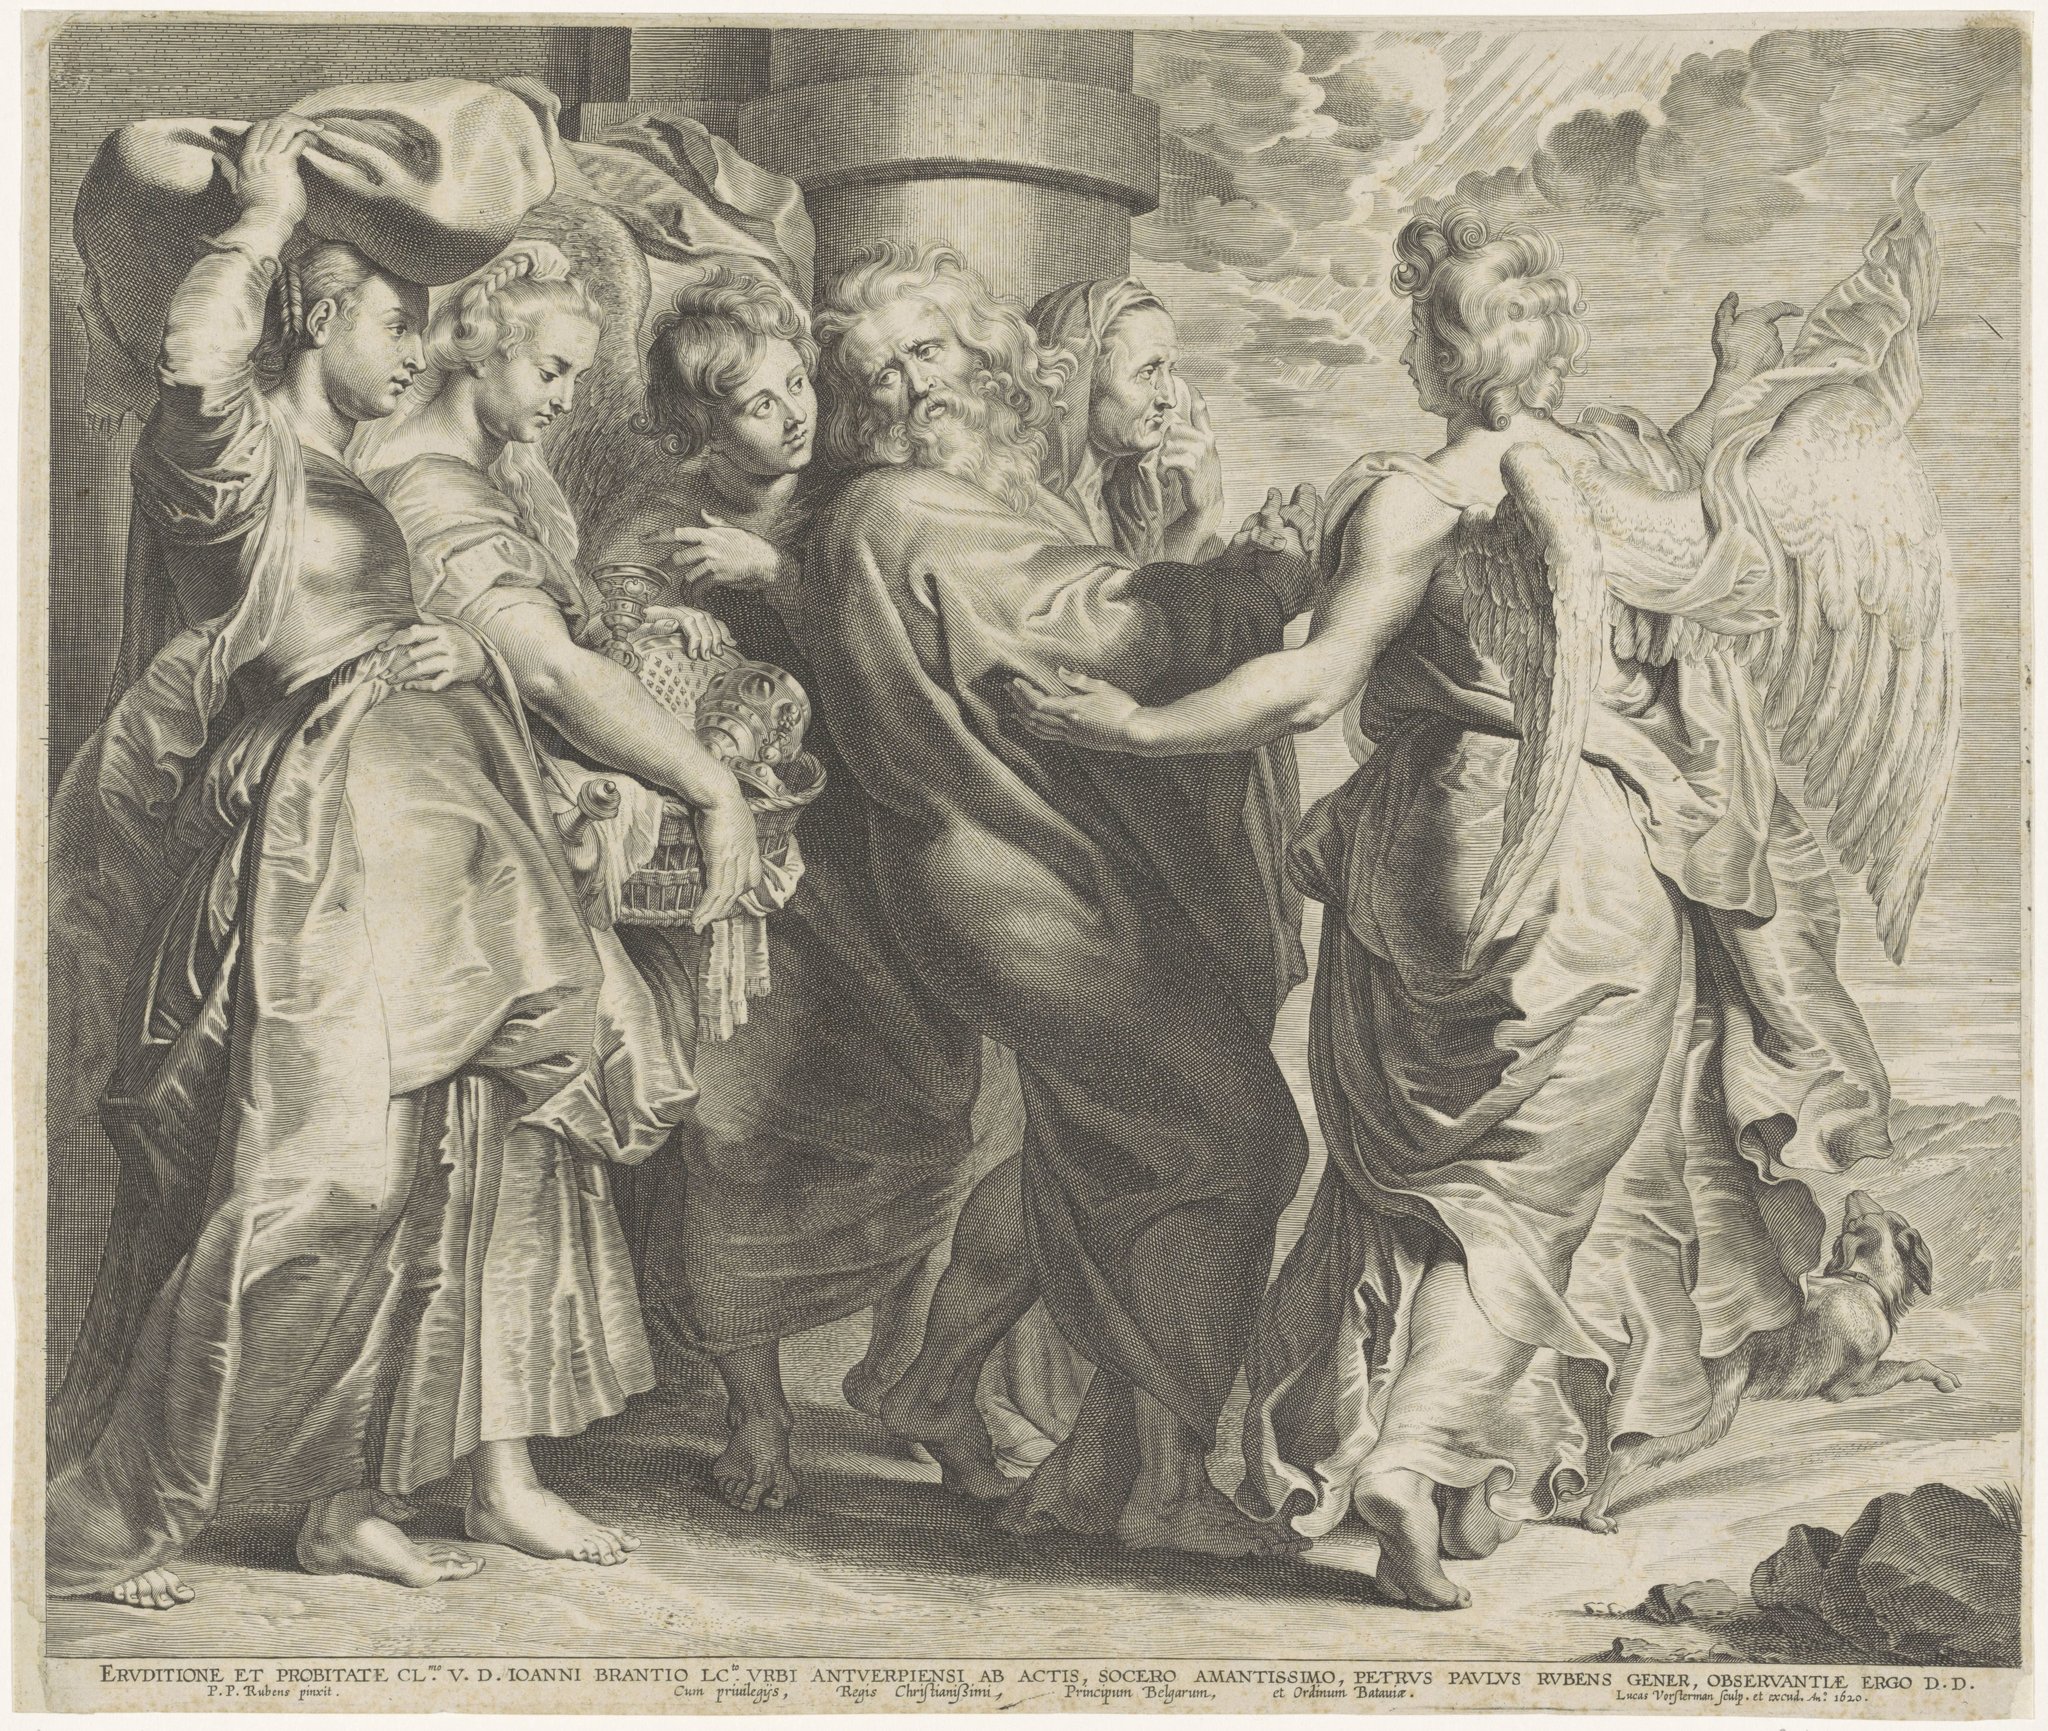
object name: print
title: Lot verlaat Sodom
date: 1620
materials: paper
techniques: engraving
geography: antwerp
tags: the destruction of sodom and gomorrah: lot and his family flee to zoar, carrying their belongings; an angel may be showing the way (genesis 19:24-29)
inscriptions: collector's mark: Lugt 10, collector's mark: Lugt 11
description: Lot verlaat met zijn familie de stad Sodom, de dochters dragen hun bezittingen. Lot wordt de weg gewezen door twee engelen. Illustratie van het Bijbelverhaal in Genesis 19:24-29.